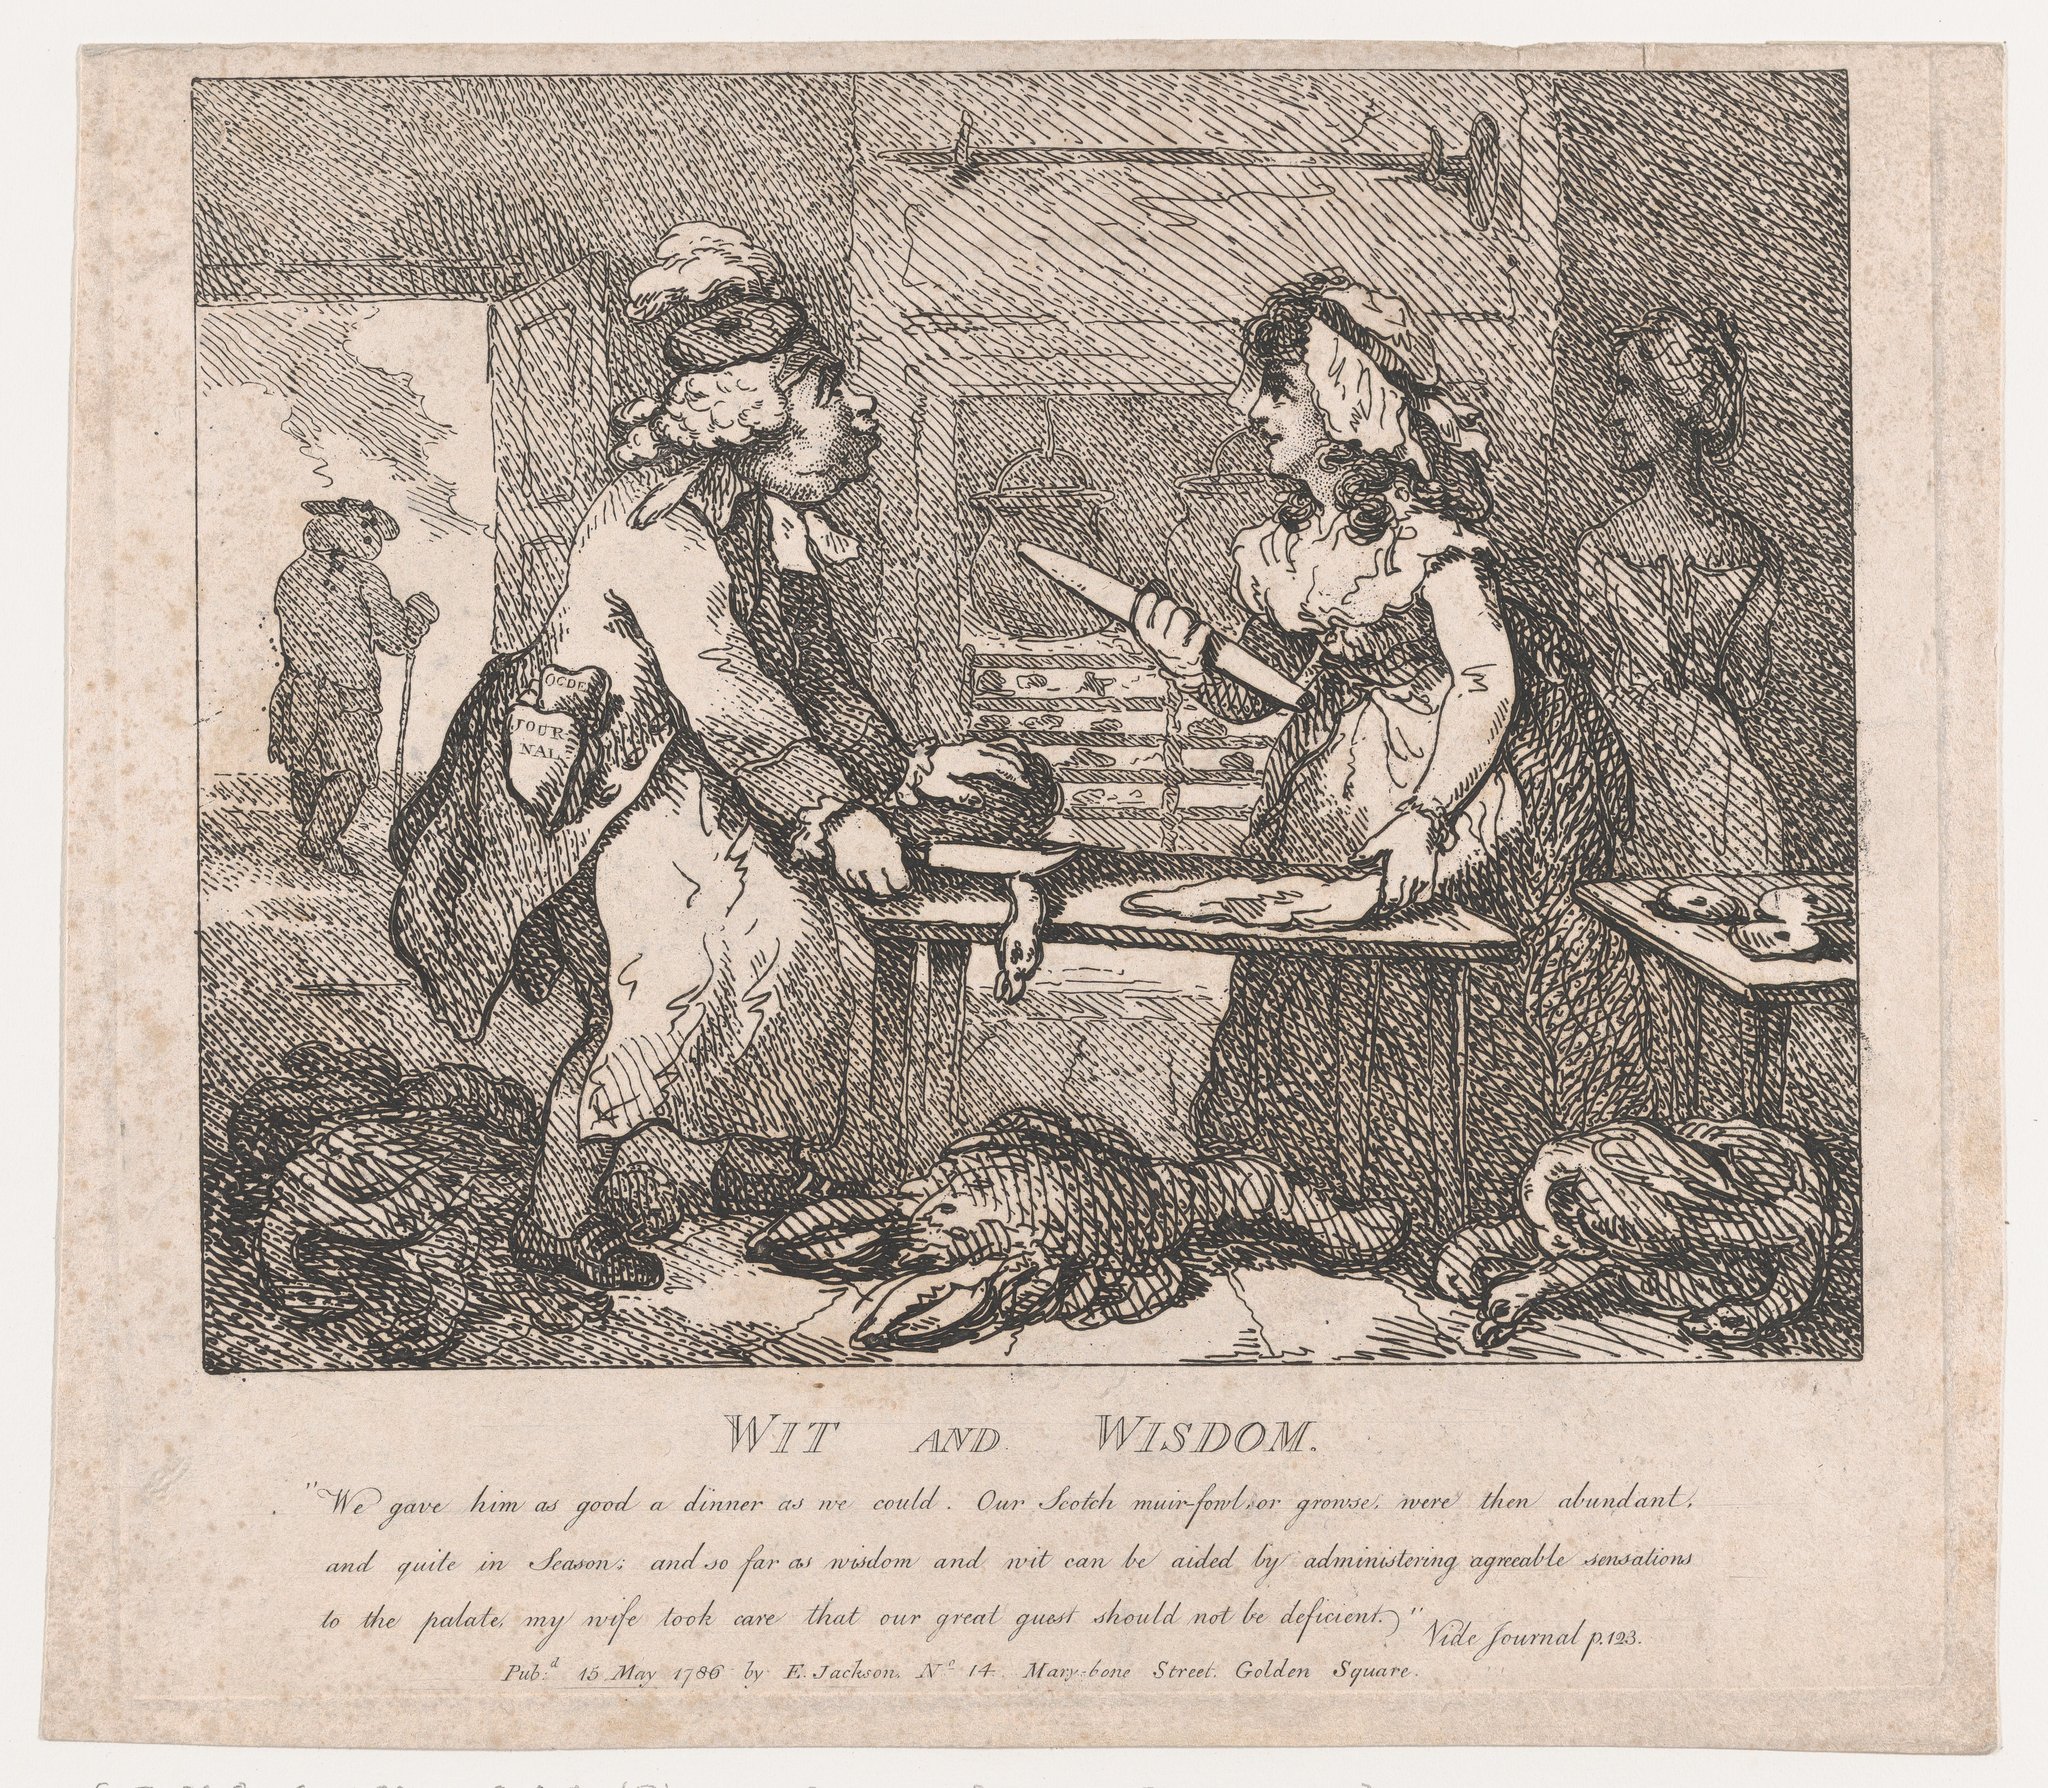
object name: print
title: Wit and Wisdom (Picturesque Beauties of Boswell, Part the First)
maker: thomas rowlandson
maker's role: artist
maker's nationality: british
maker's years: 1757-1827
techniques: etching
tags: satire,kitchens,men,women